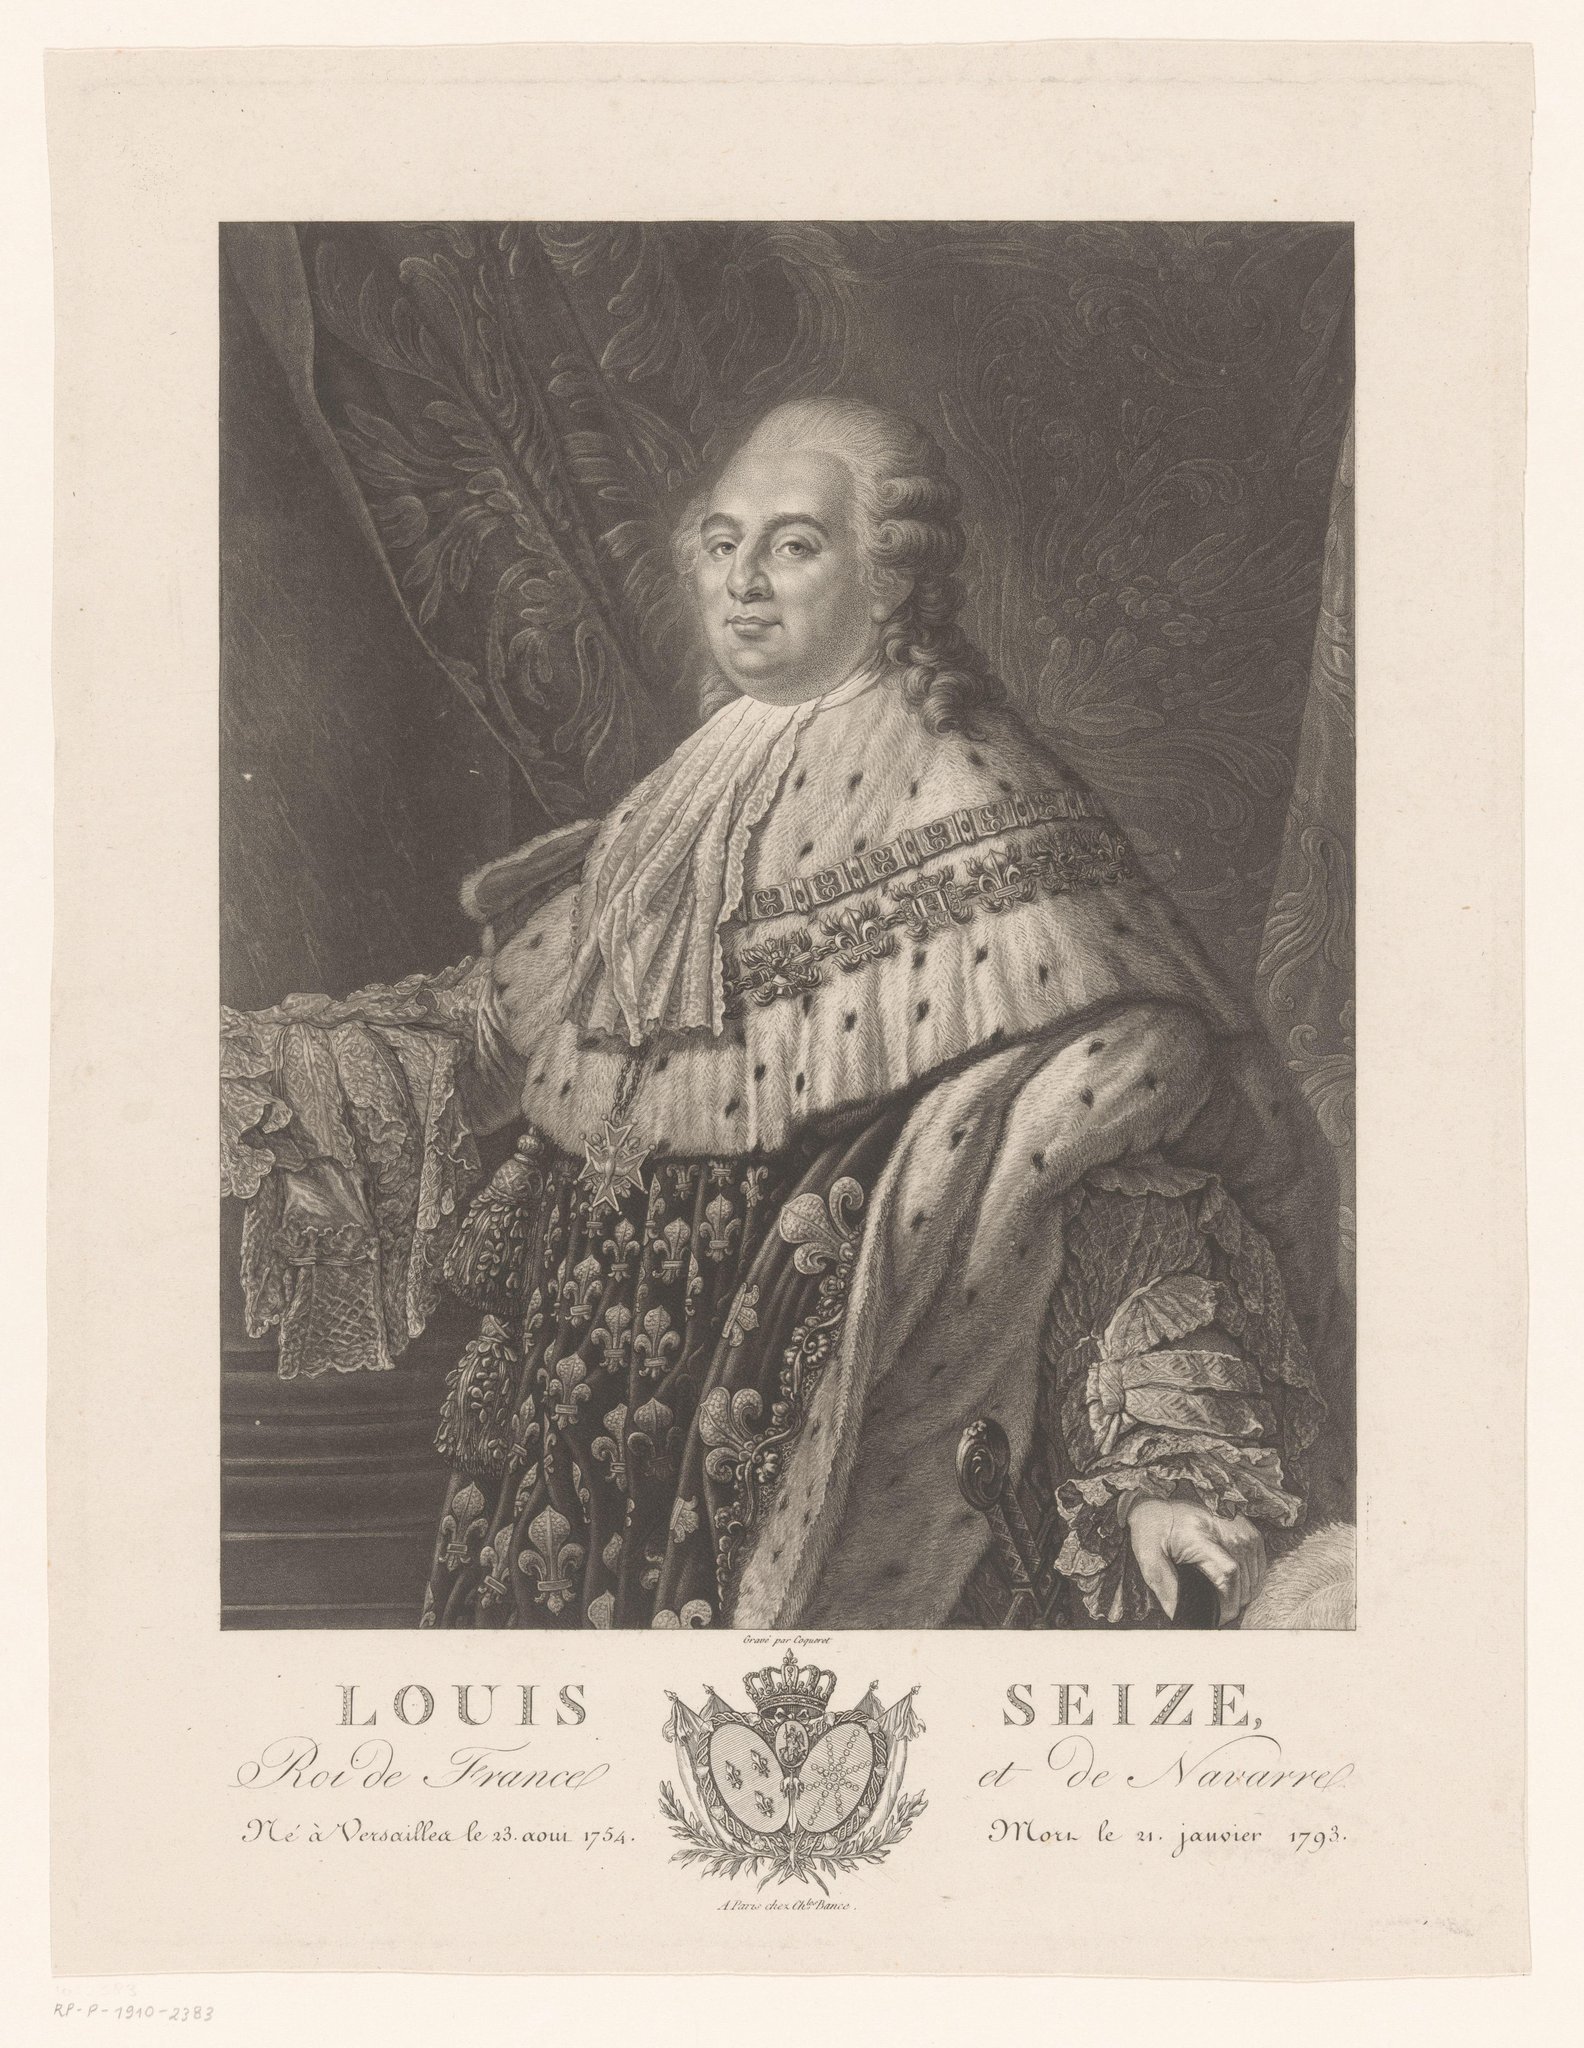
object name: print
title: Louis seize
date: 1781-1832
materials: paper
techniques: aquatint, etching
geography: france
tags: paris, lodewijk xvi (koning van frankrijk), historical persons, ruler, sovereign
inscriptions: collector's mark: Lugt 2228